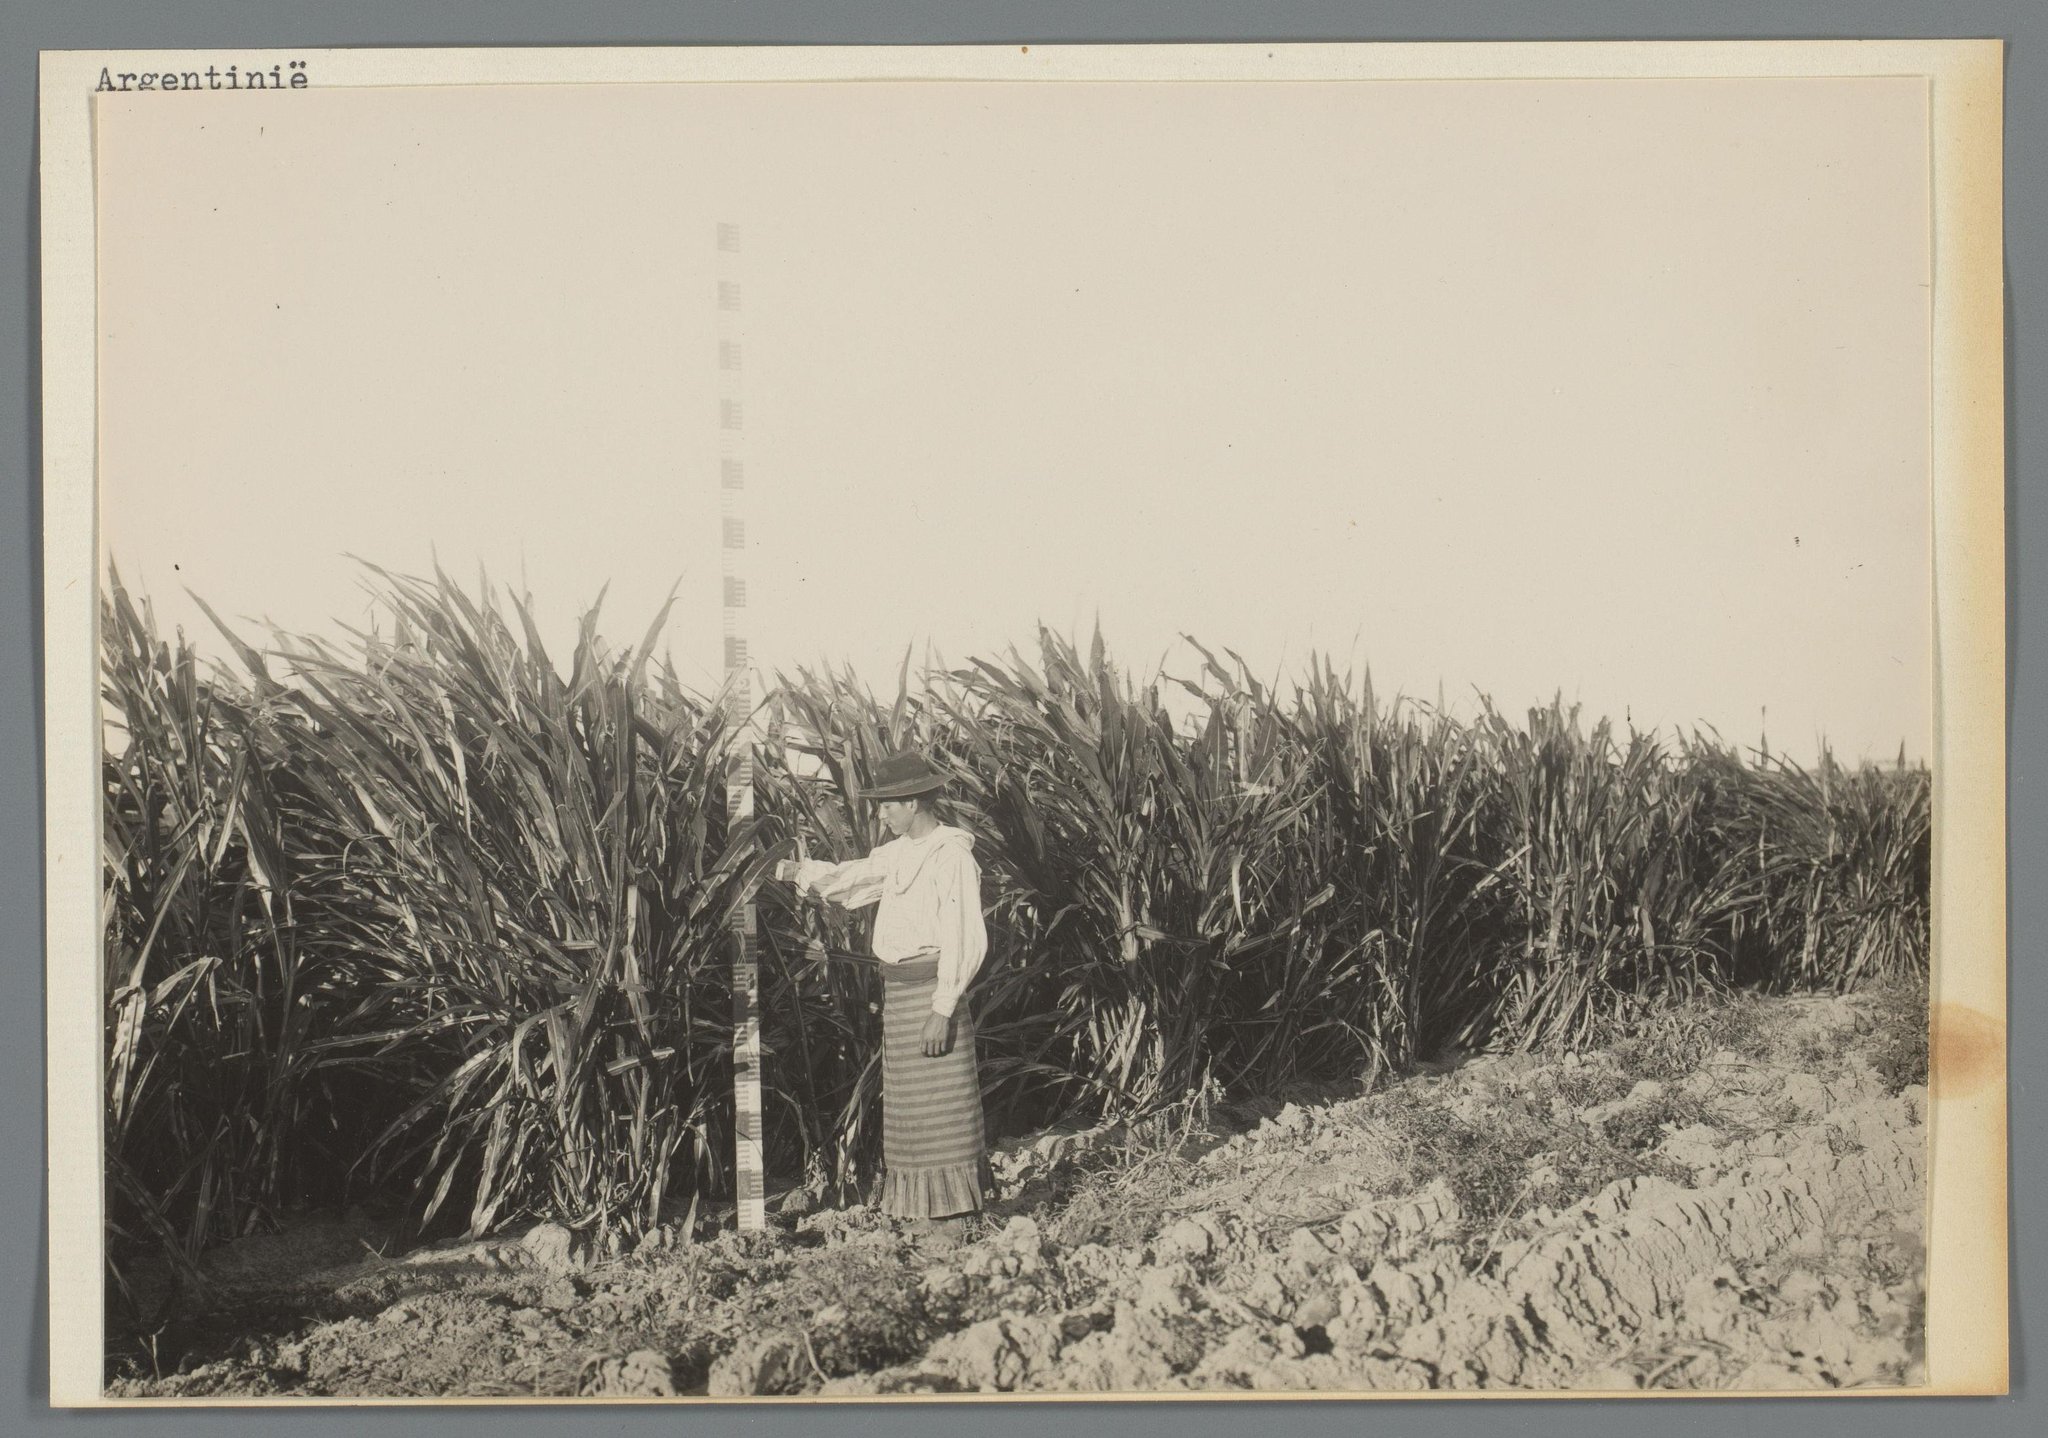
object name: photograph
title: Vrouw meet de hoogte van suikerrietplanten op een plantage in Argentinië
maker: Anonymous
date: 1900-1930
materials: paper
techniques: gelatin silver print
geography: argentinië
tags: plantation, sugar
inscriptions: inscription: ‘Una plantación de caña de azúcar. (1)/ (1) Une plantation de canne à sucre.-’, inscription: ‘Una plantación de caña de azúcar (suikerriet)’, number: ‘970000’, number: ‘40.911’, stamp: ‘REPÚBLICA ARGENTINA/ MINISTERIO D'AGRICULTURA DE LA MACIOR/ [...]/ DIVISION FOTO-CINEMATOGRAFIA’